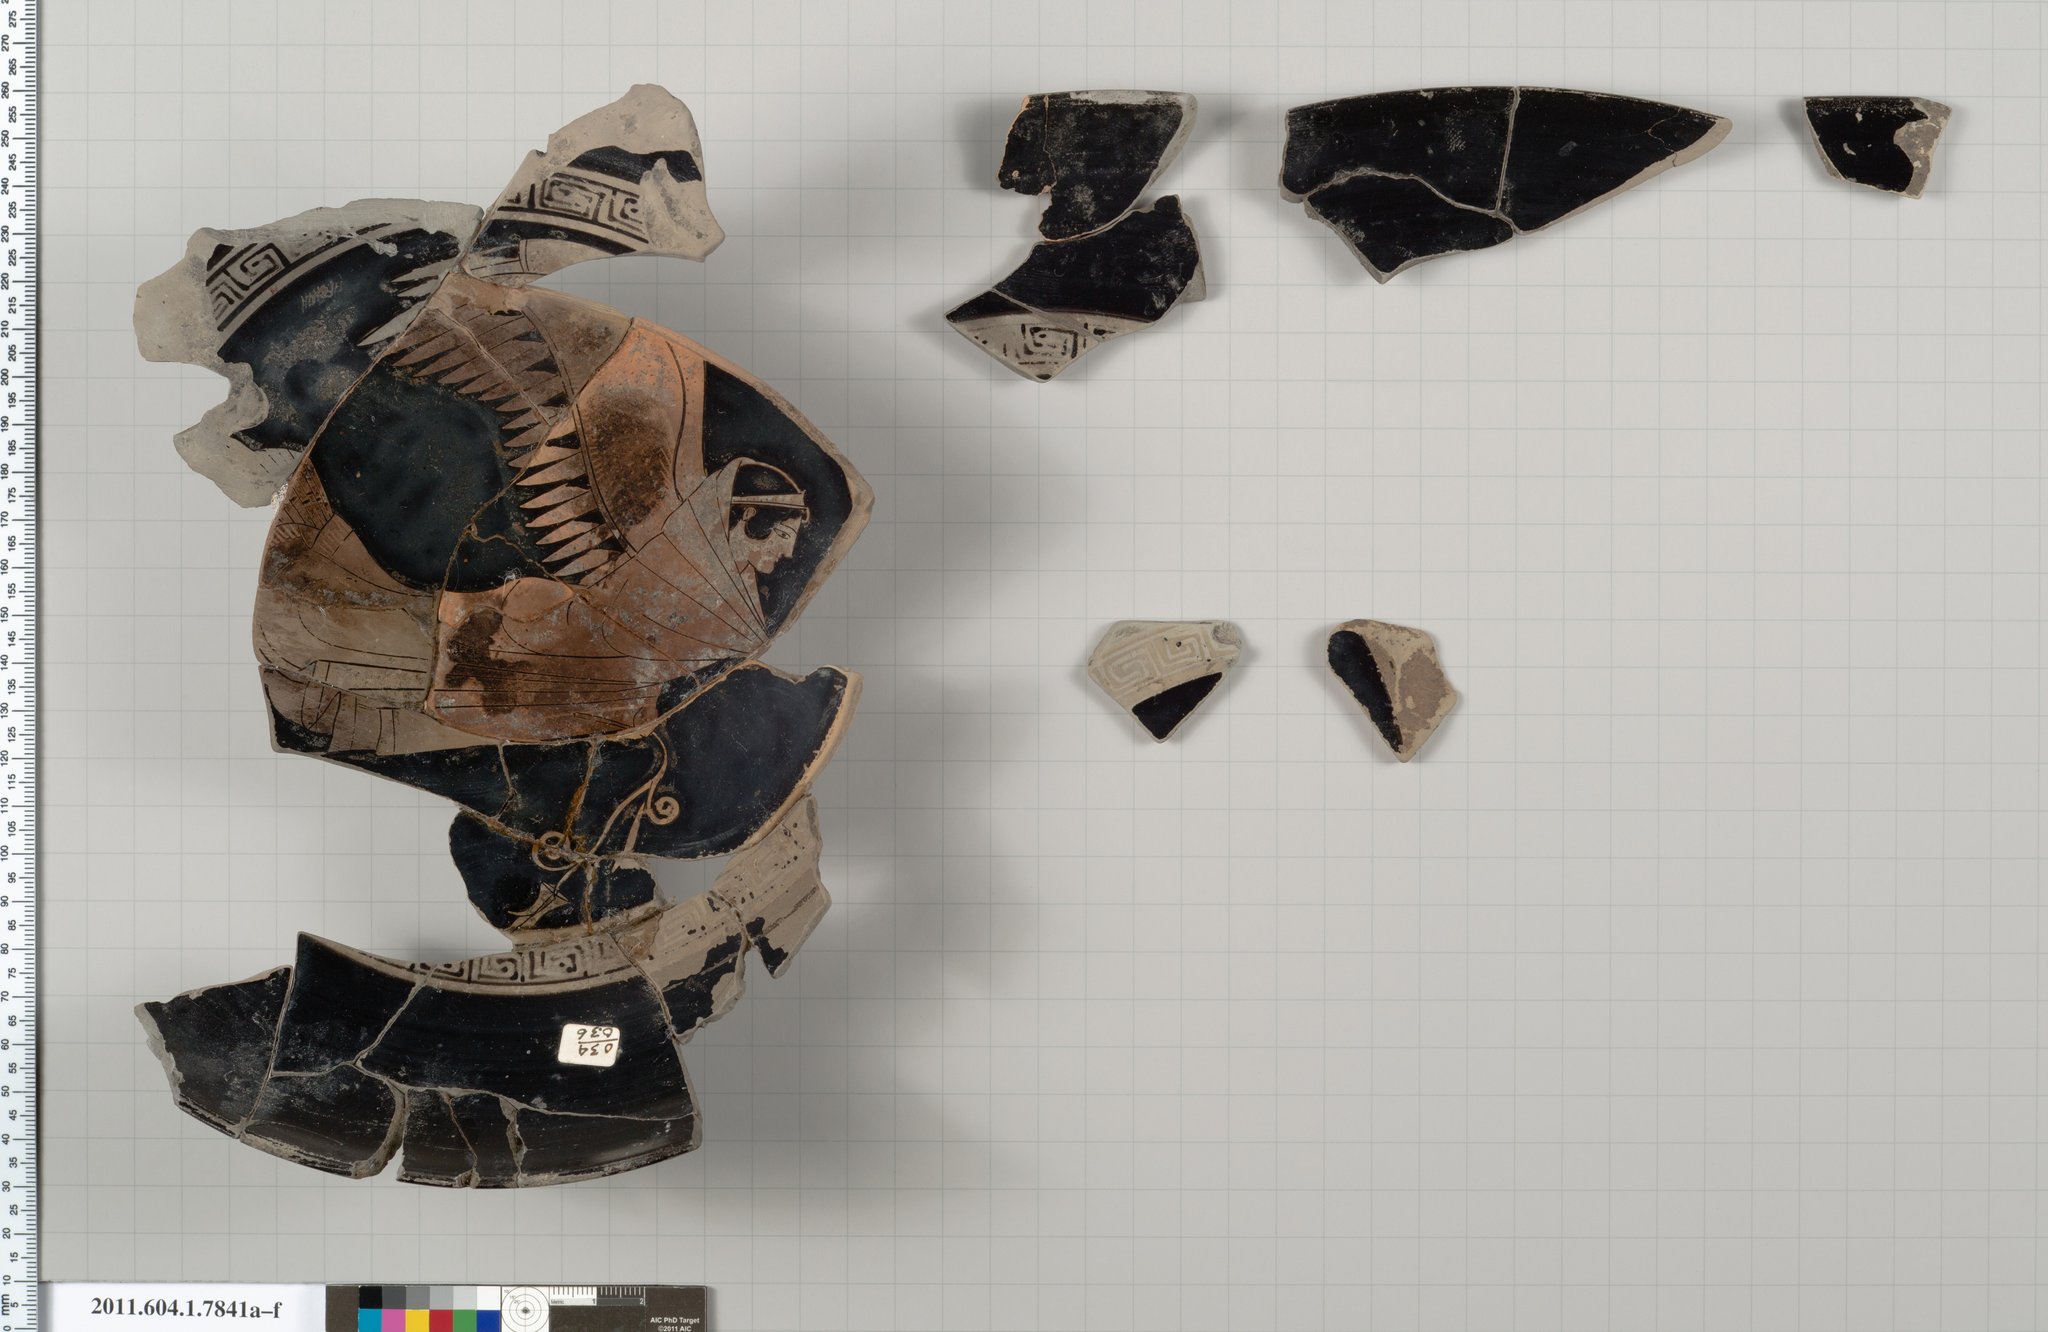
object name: kylix fragment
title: Terracotta fragments of a kylix (drinking cup)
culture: greek, attic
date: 460 BCE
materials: terracotta